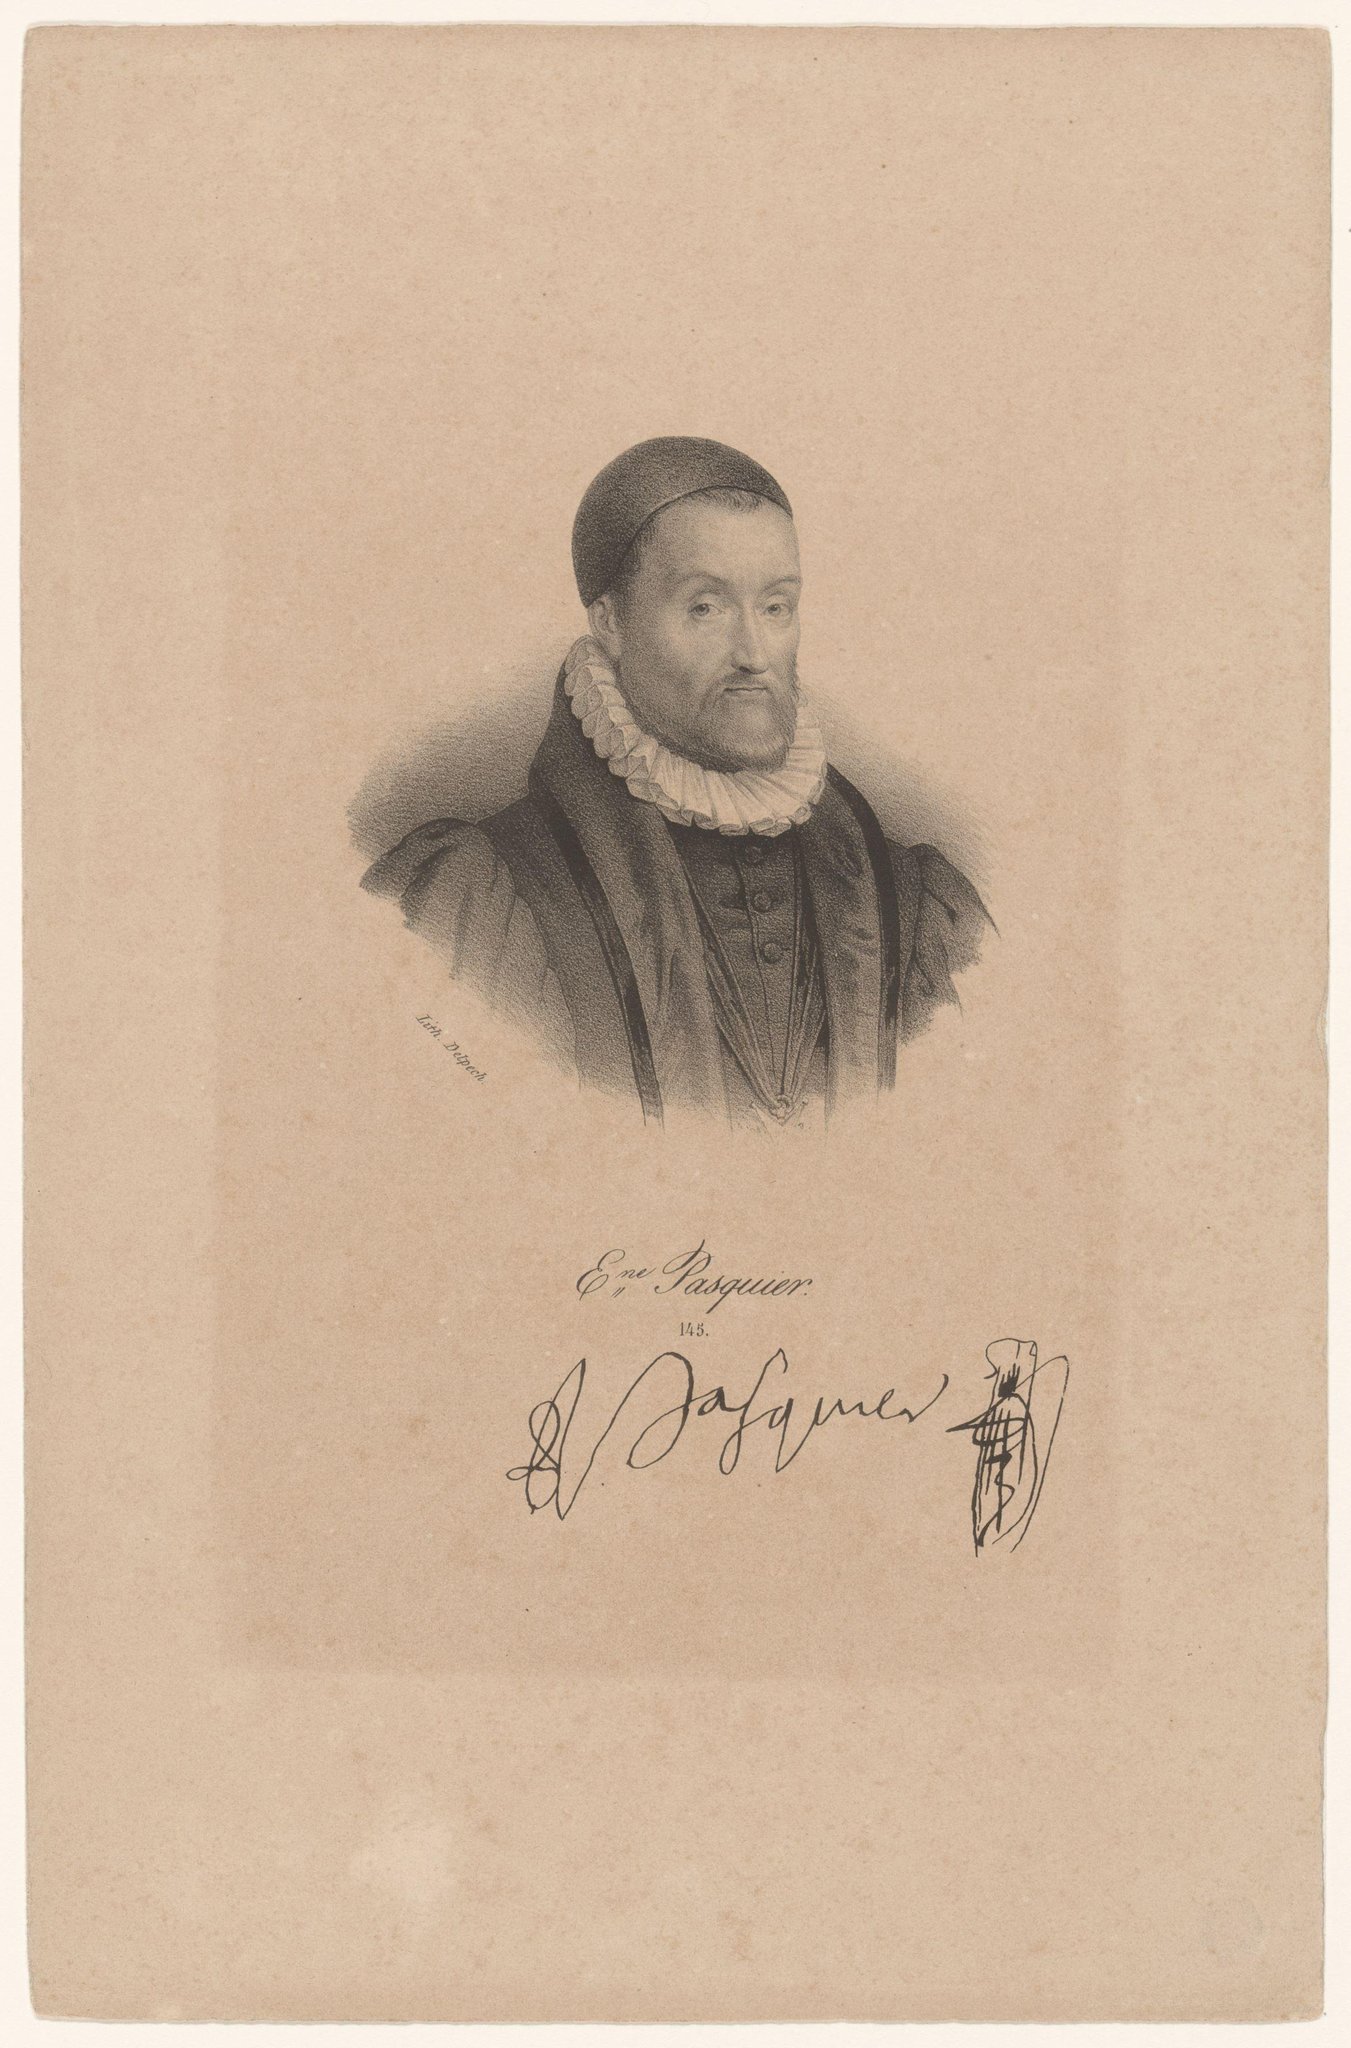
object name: print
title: E.ne Pasquier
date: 1818-1842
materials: paper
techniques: lithograph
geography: paris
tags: historical persons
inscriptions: collector's mark: Lugt 2228a